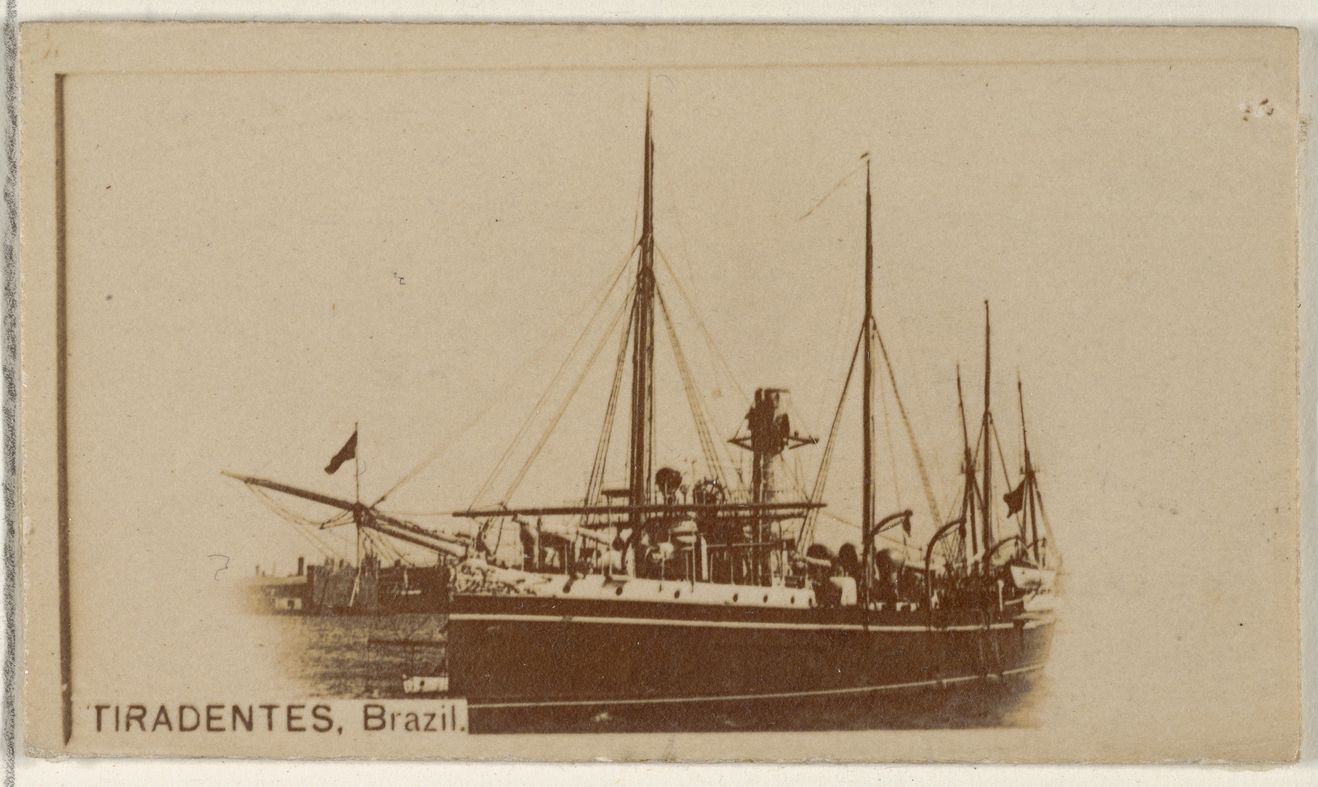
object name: photograph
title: Tiradentes, Brazil, from the Famous Ships series (N50) for Virginia Brights Cigarettes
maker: allen & ginter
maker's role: publisher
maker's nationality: american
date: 1895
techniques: albumen silver print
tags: ships